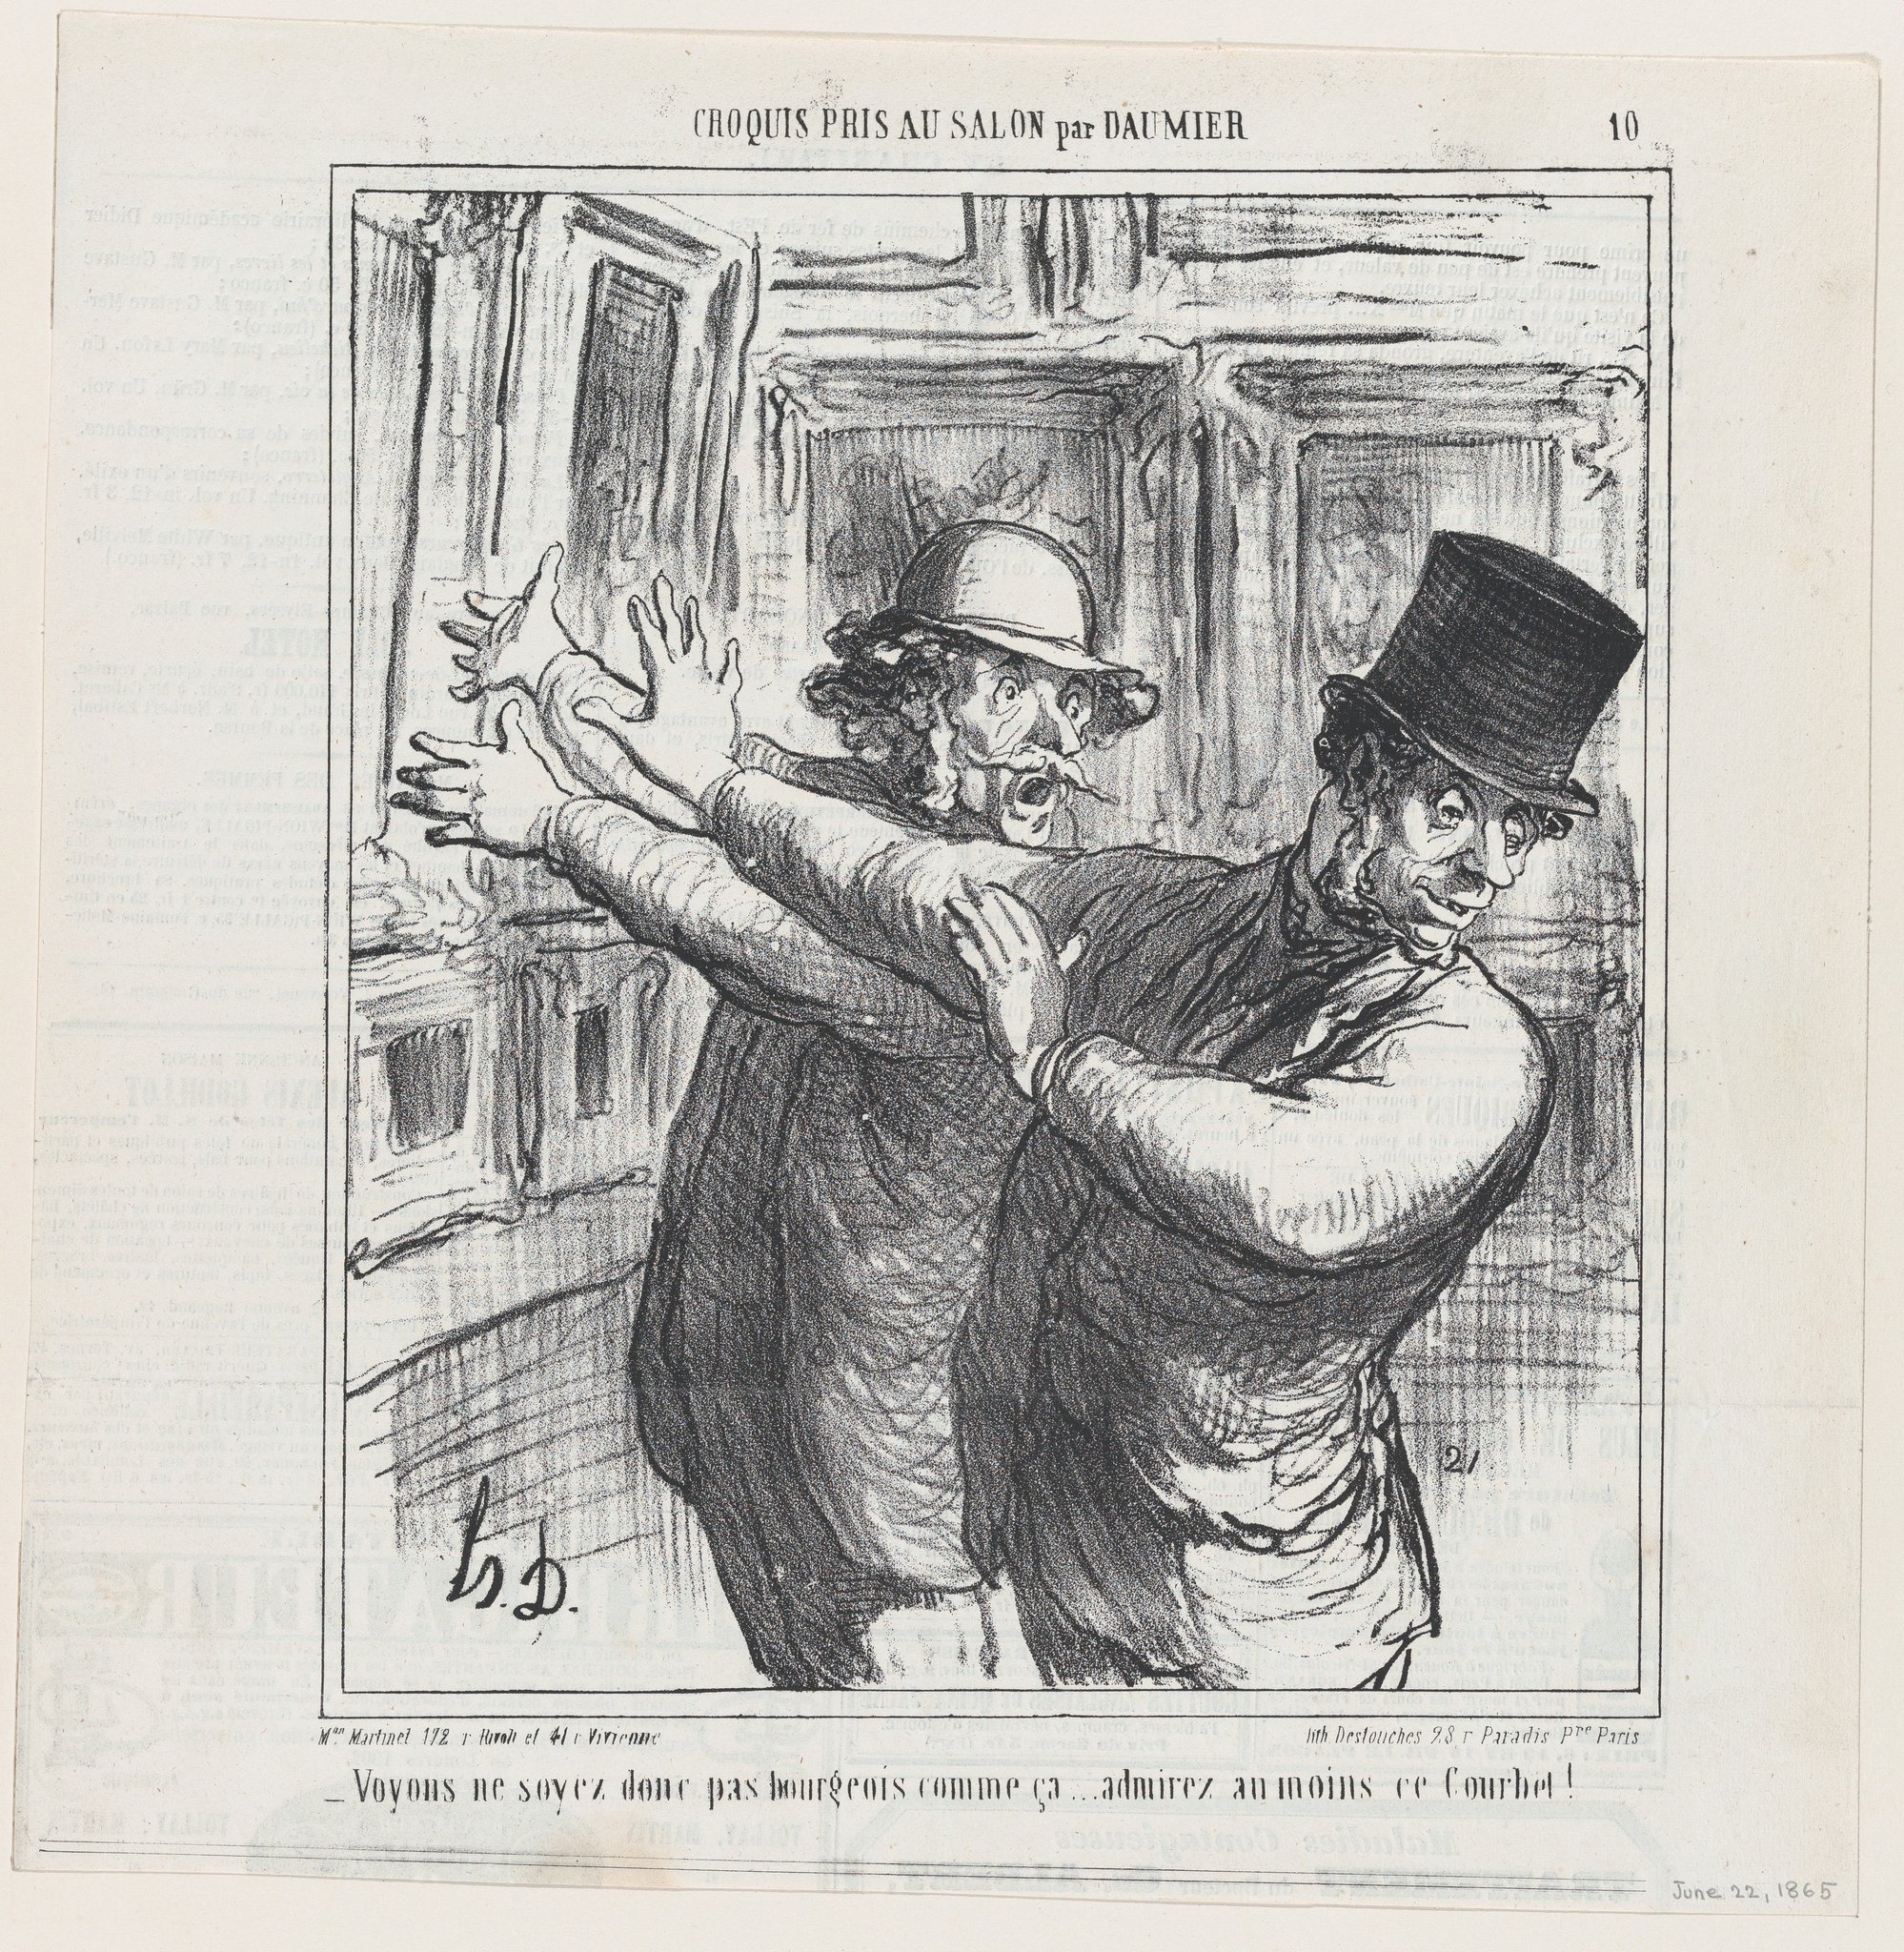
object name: print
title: Come on... don't be such a bourgeois.... at least have a look at this Courbet!, from 'Sketches from the Salon,' published in Le Charivari, June 22, 1865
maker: honoré daumier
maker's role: artist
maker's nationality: french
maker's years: 1808-1879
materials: paper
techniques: lithograph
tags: satire,men